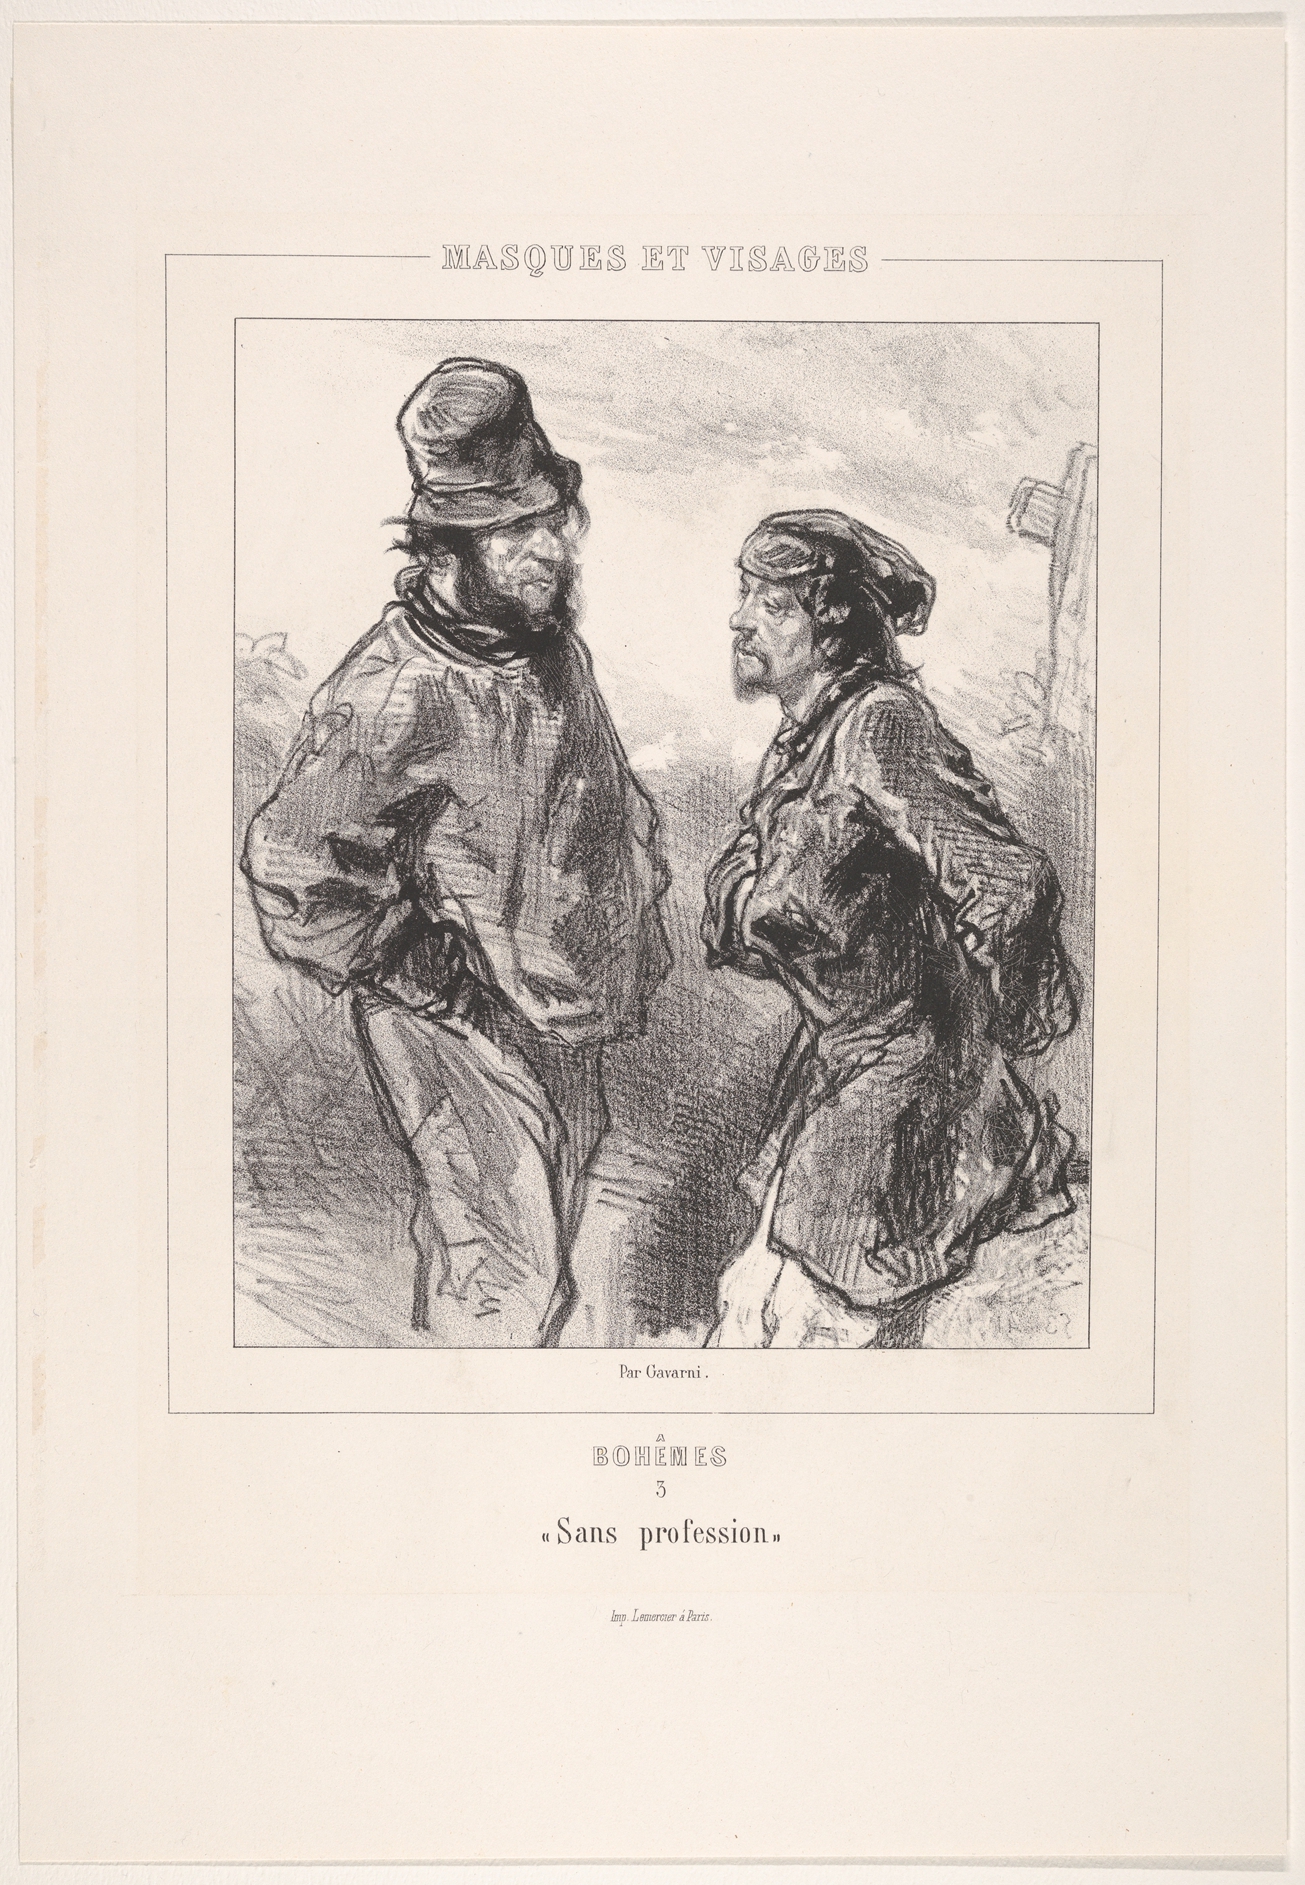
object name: print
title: Sans profession, from "Bohèmes, Masques et Visages"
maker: paul gavarni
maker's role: artist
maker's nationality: french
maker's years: 1804-1866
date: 1801-1900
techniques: lithograph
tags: men